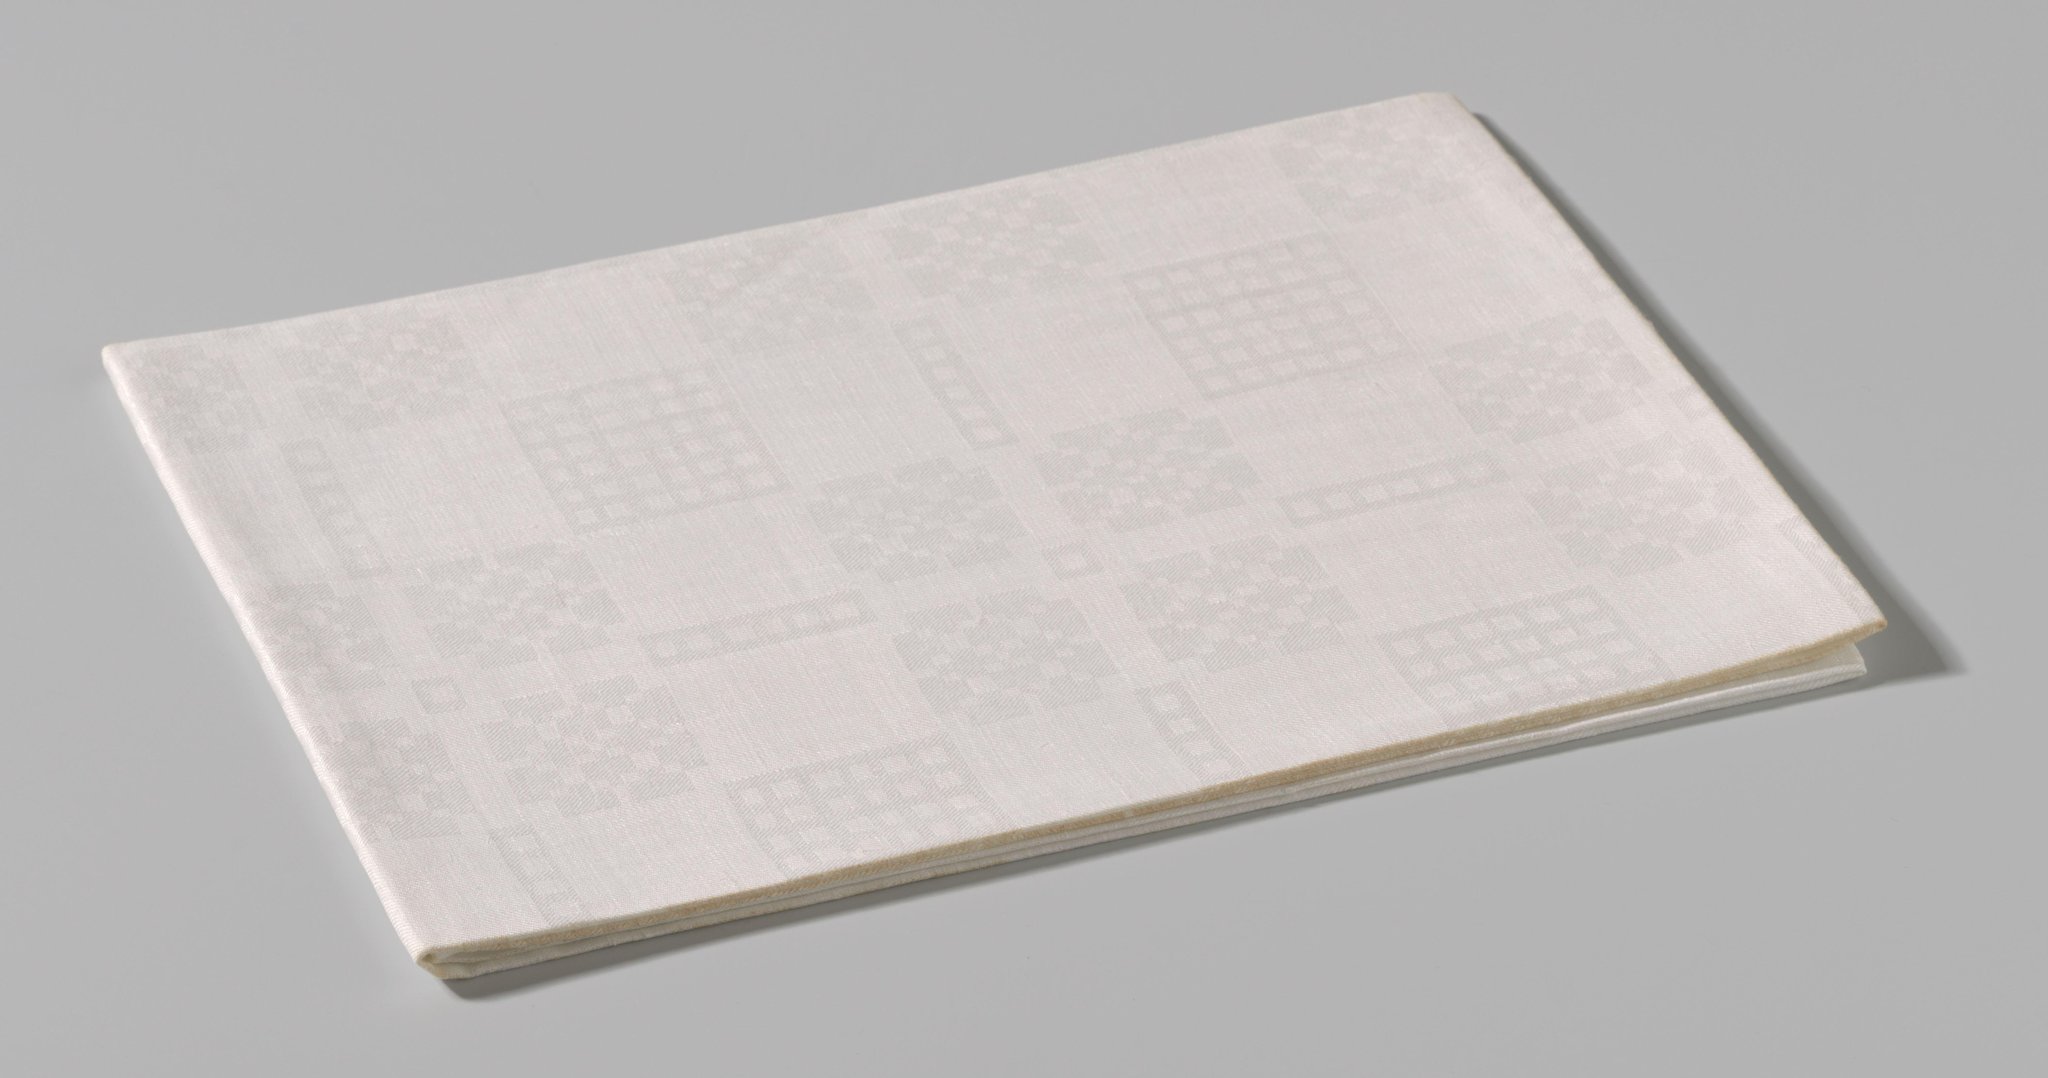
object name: napkin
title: Servet met pellenpatroon met wafelruit en bloemvorm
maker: Anonymous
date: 1675-1725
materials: linen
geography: northern netherlands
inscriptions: mark: ‘K’, mark: ‘BS’, mark: ‘48’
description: Servet van wit linnen met een pellen patroon in keper, een wafelruitje met een soort bloem, merk BS en 48.